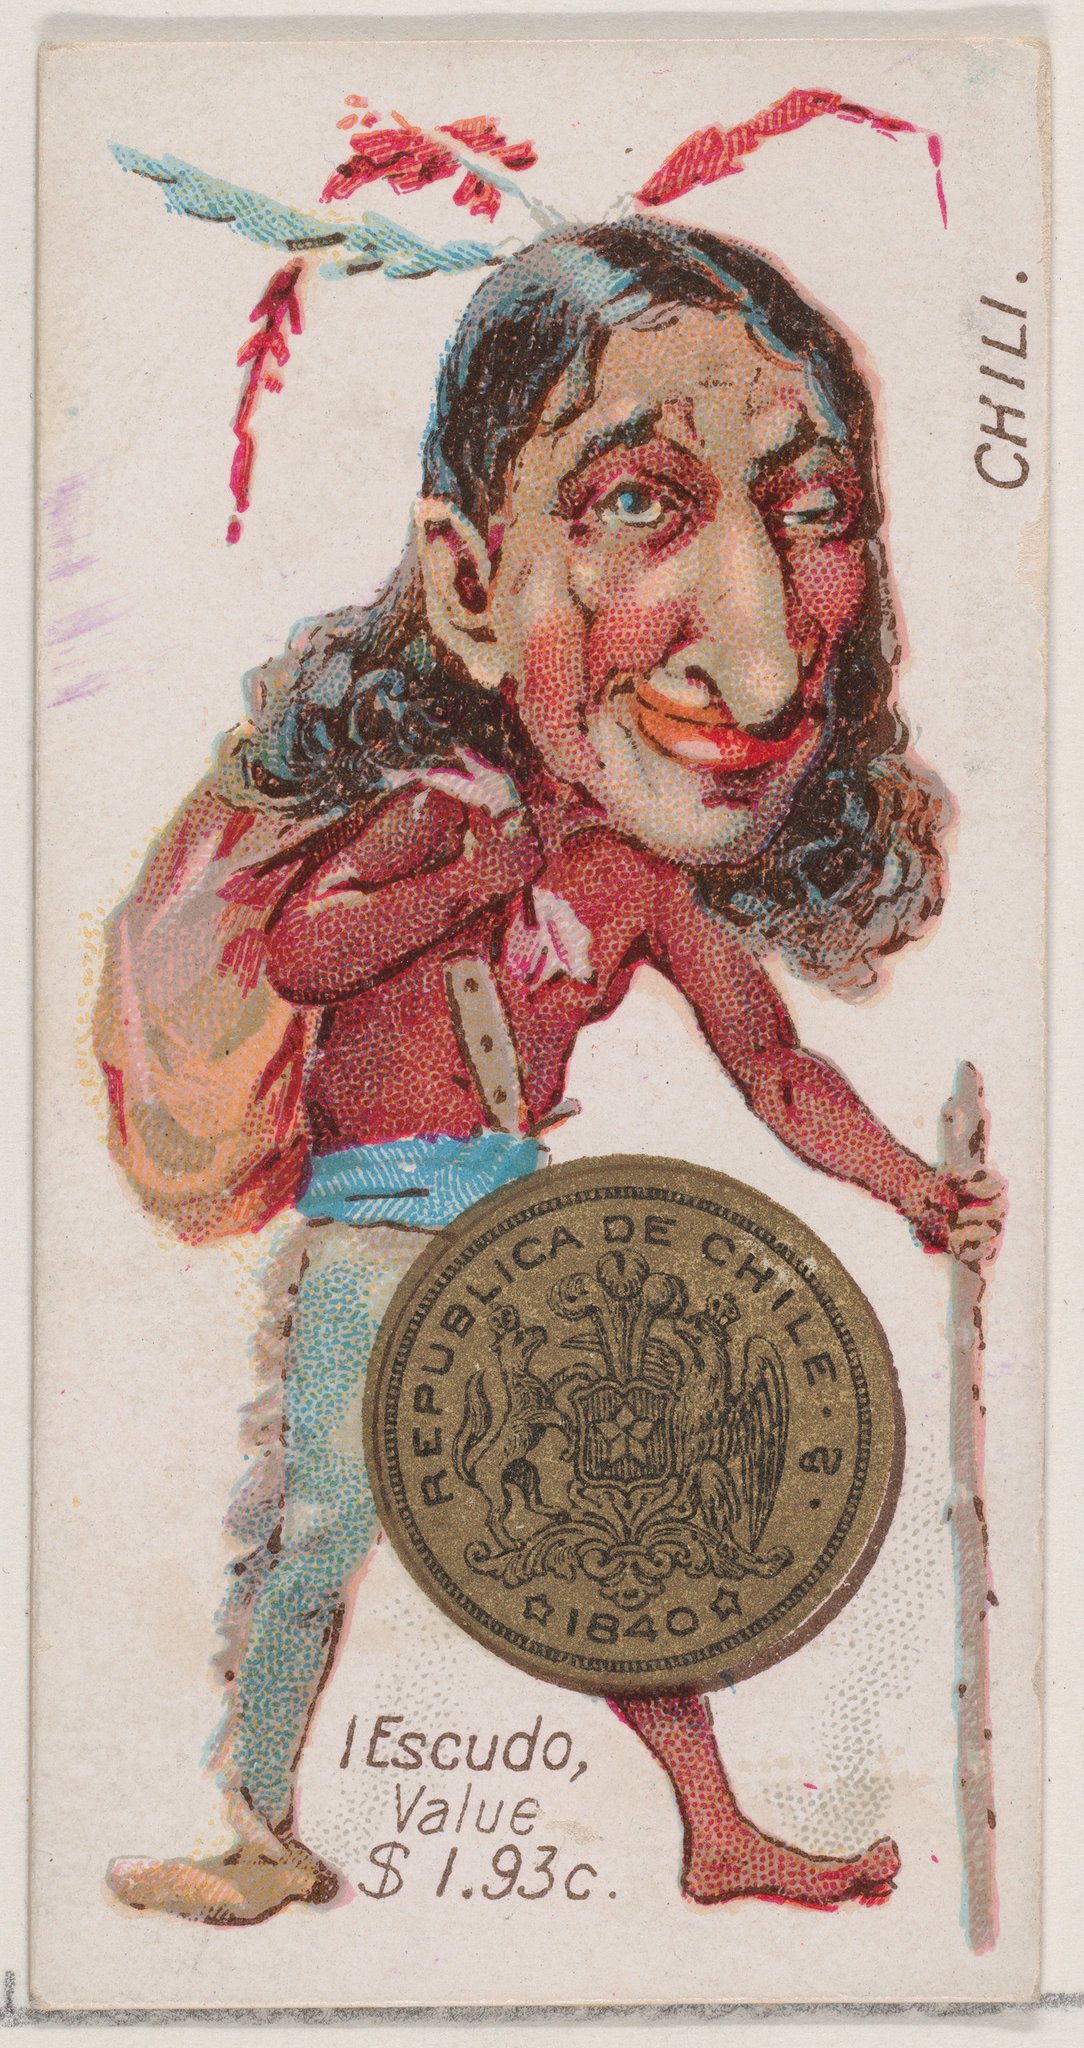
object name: print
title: Caricatured Chilean figure, 1 Escudo, from the series Coins of All Nations (N72, variation 1) for Duke brand cigarettes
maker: w. duke, sons & co.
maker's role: publisher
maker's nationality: american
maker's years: 1870-1920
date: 1889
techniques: color lithograph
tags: men,coins